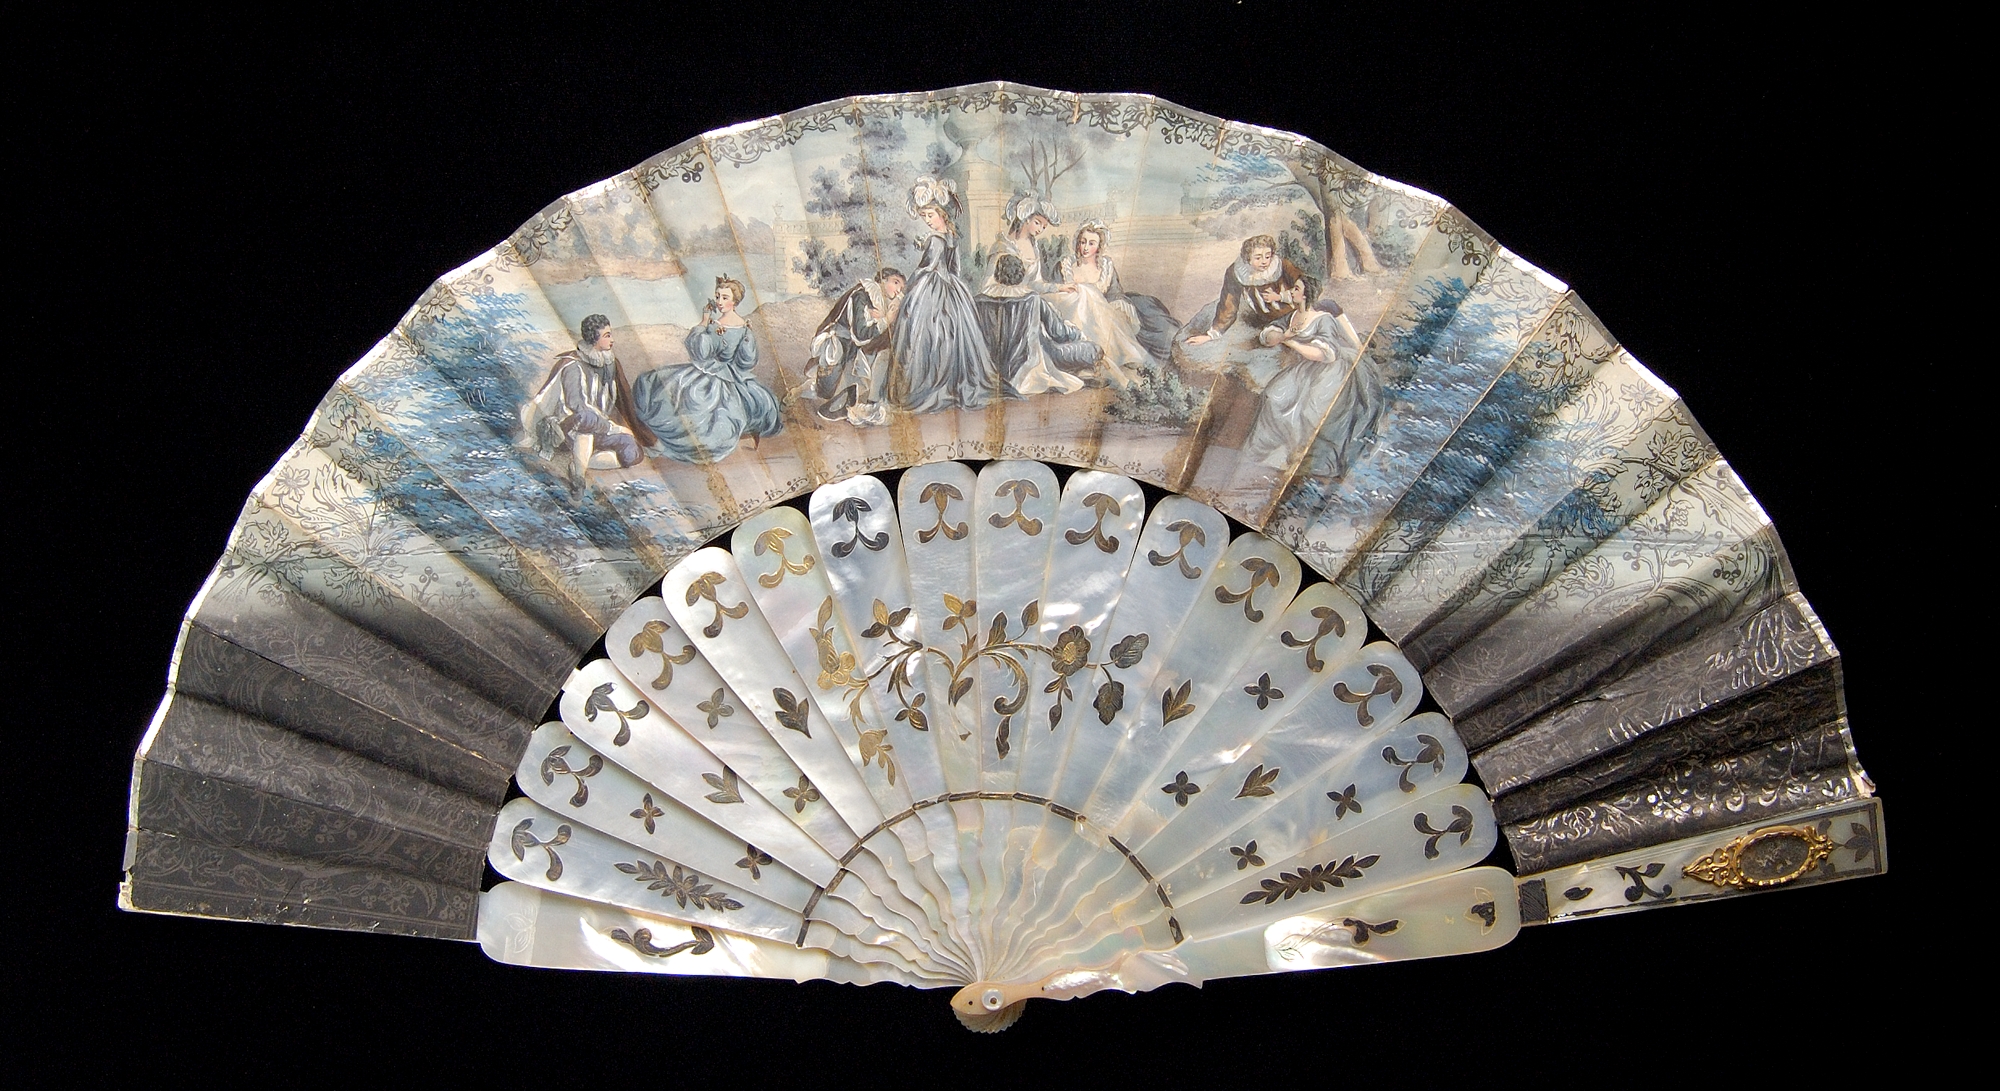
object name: fan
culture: european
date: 1855-1865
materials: glass, metal, mother of pearl, paper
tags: men,women